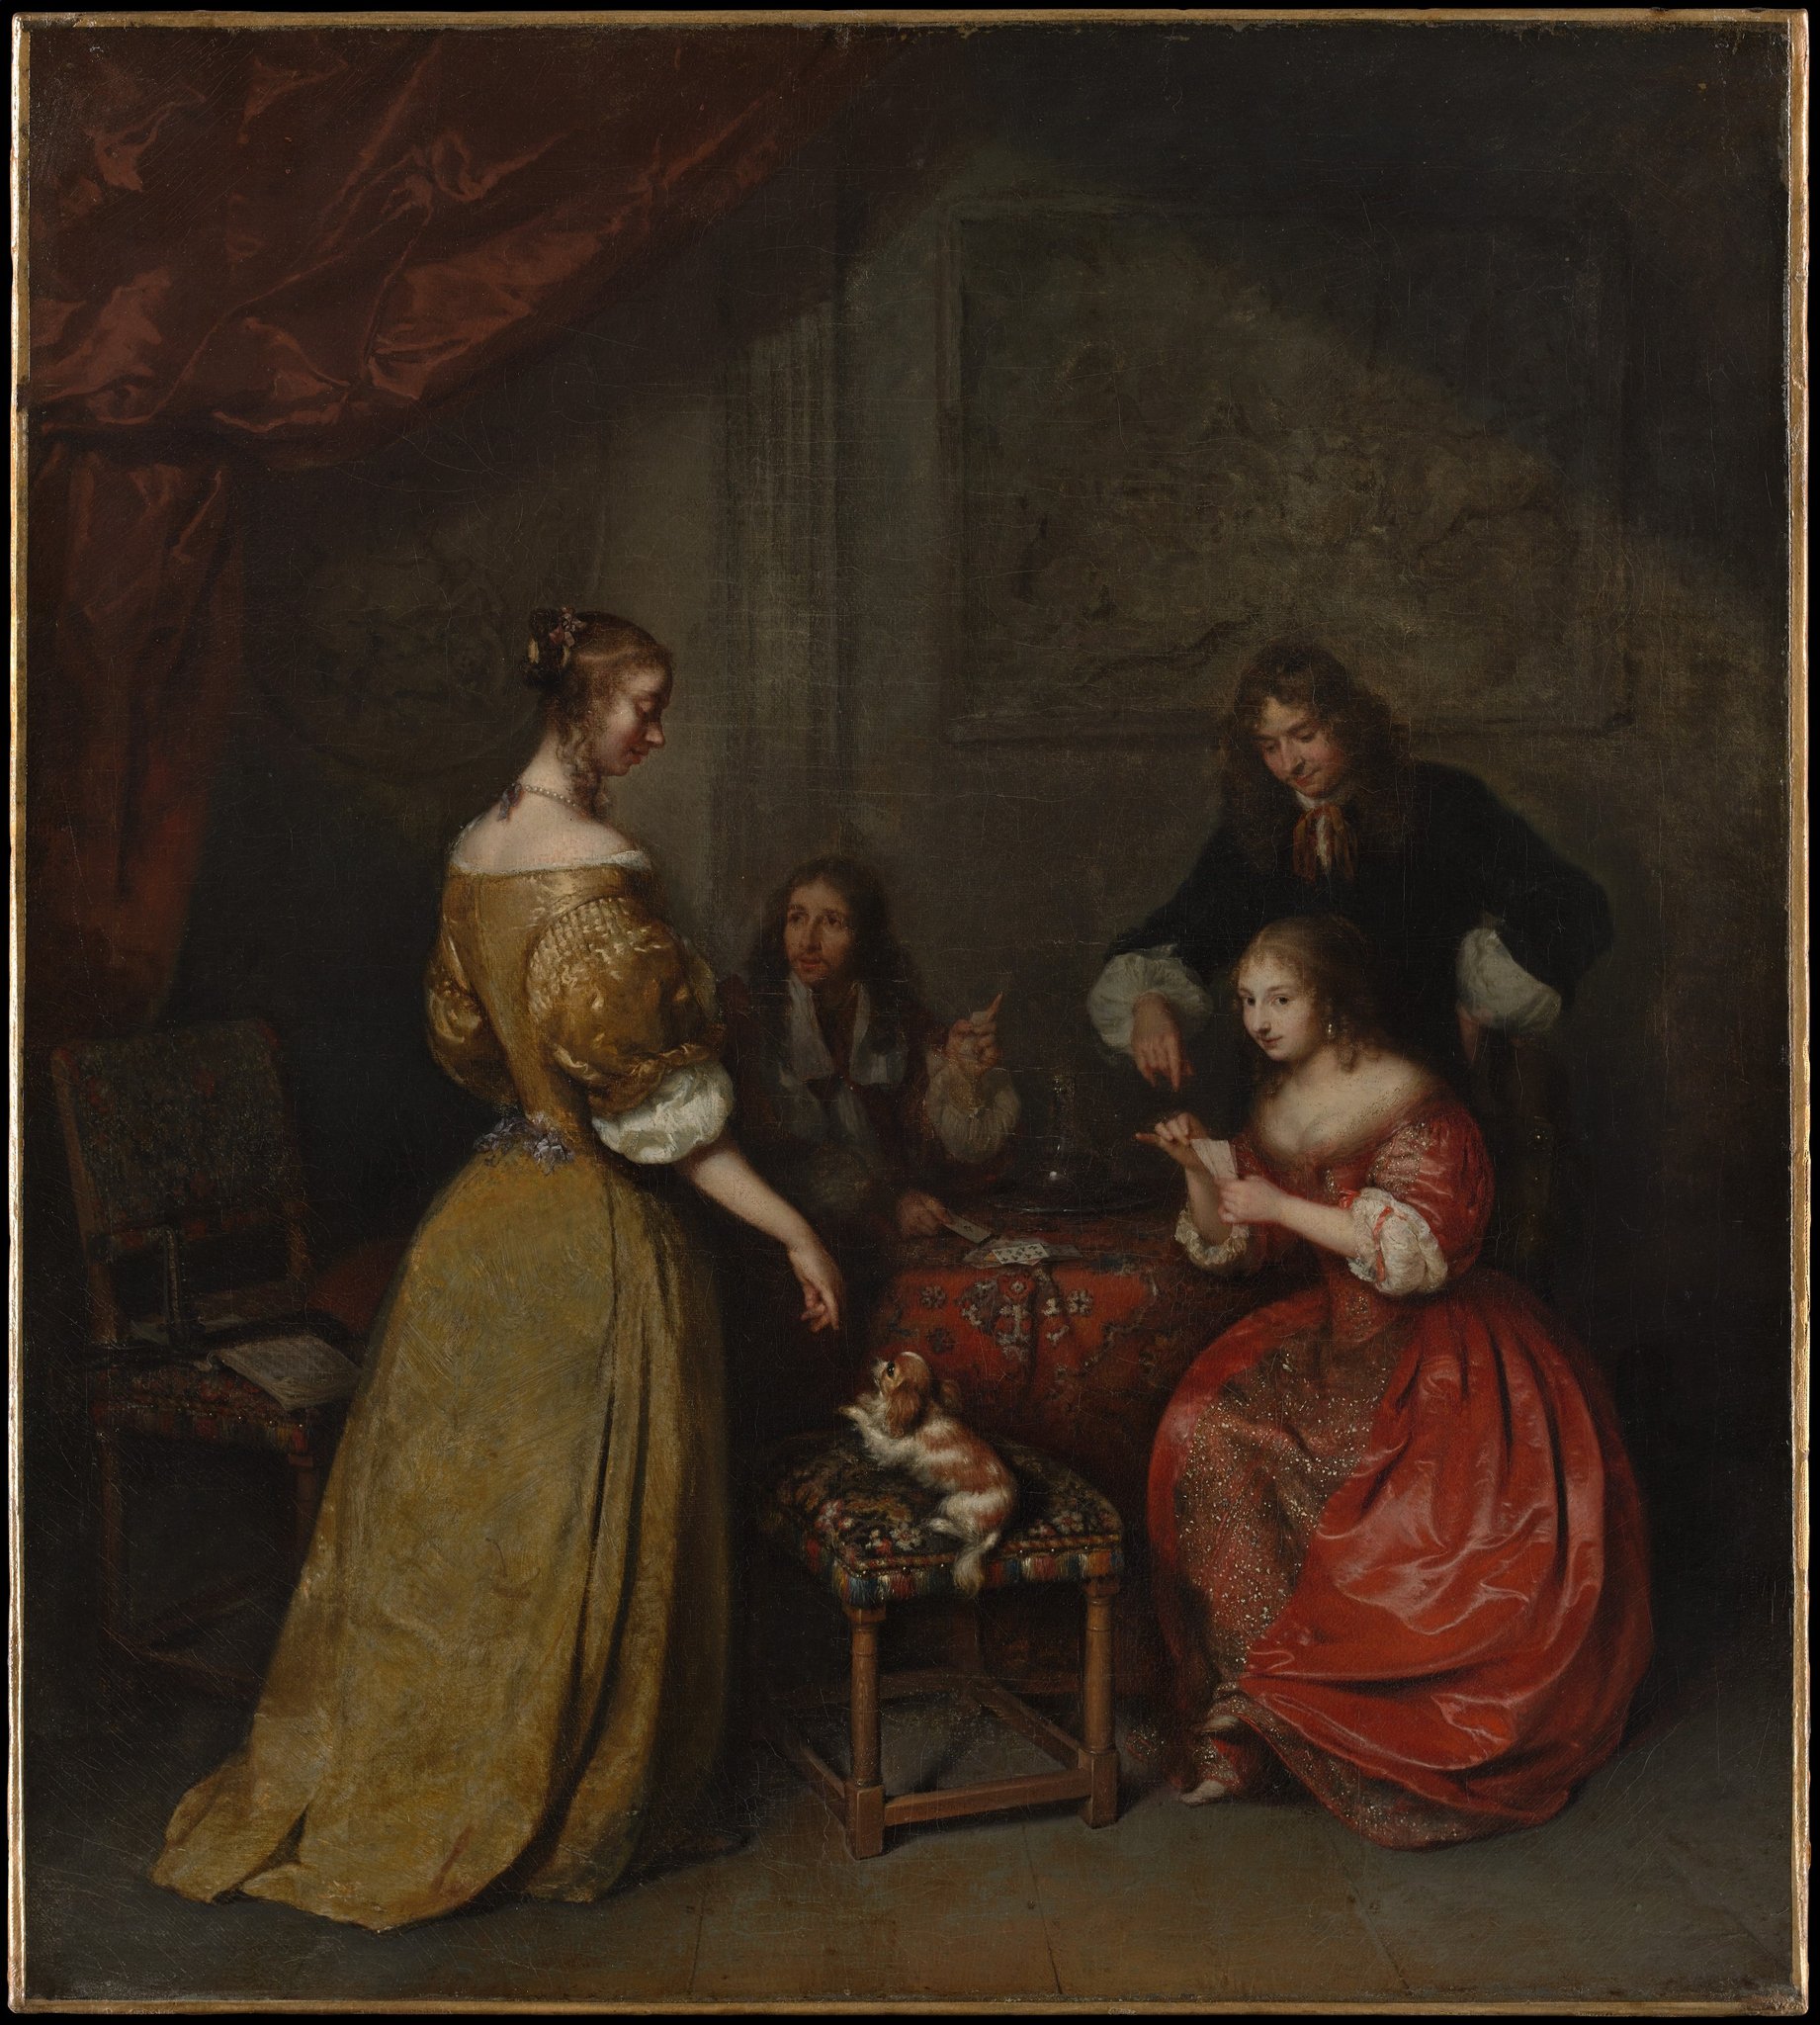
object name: painting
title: The Card Party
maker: caspar netscher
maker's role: artist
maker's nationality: dutch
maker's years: 1639-1684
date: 1665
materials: canvas, oil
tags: interiors,men,women,playing cards,dogs,games